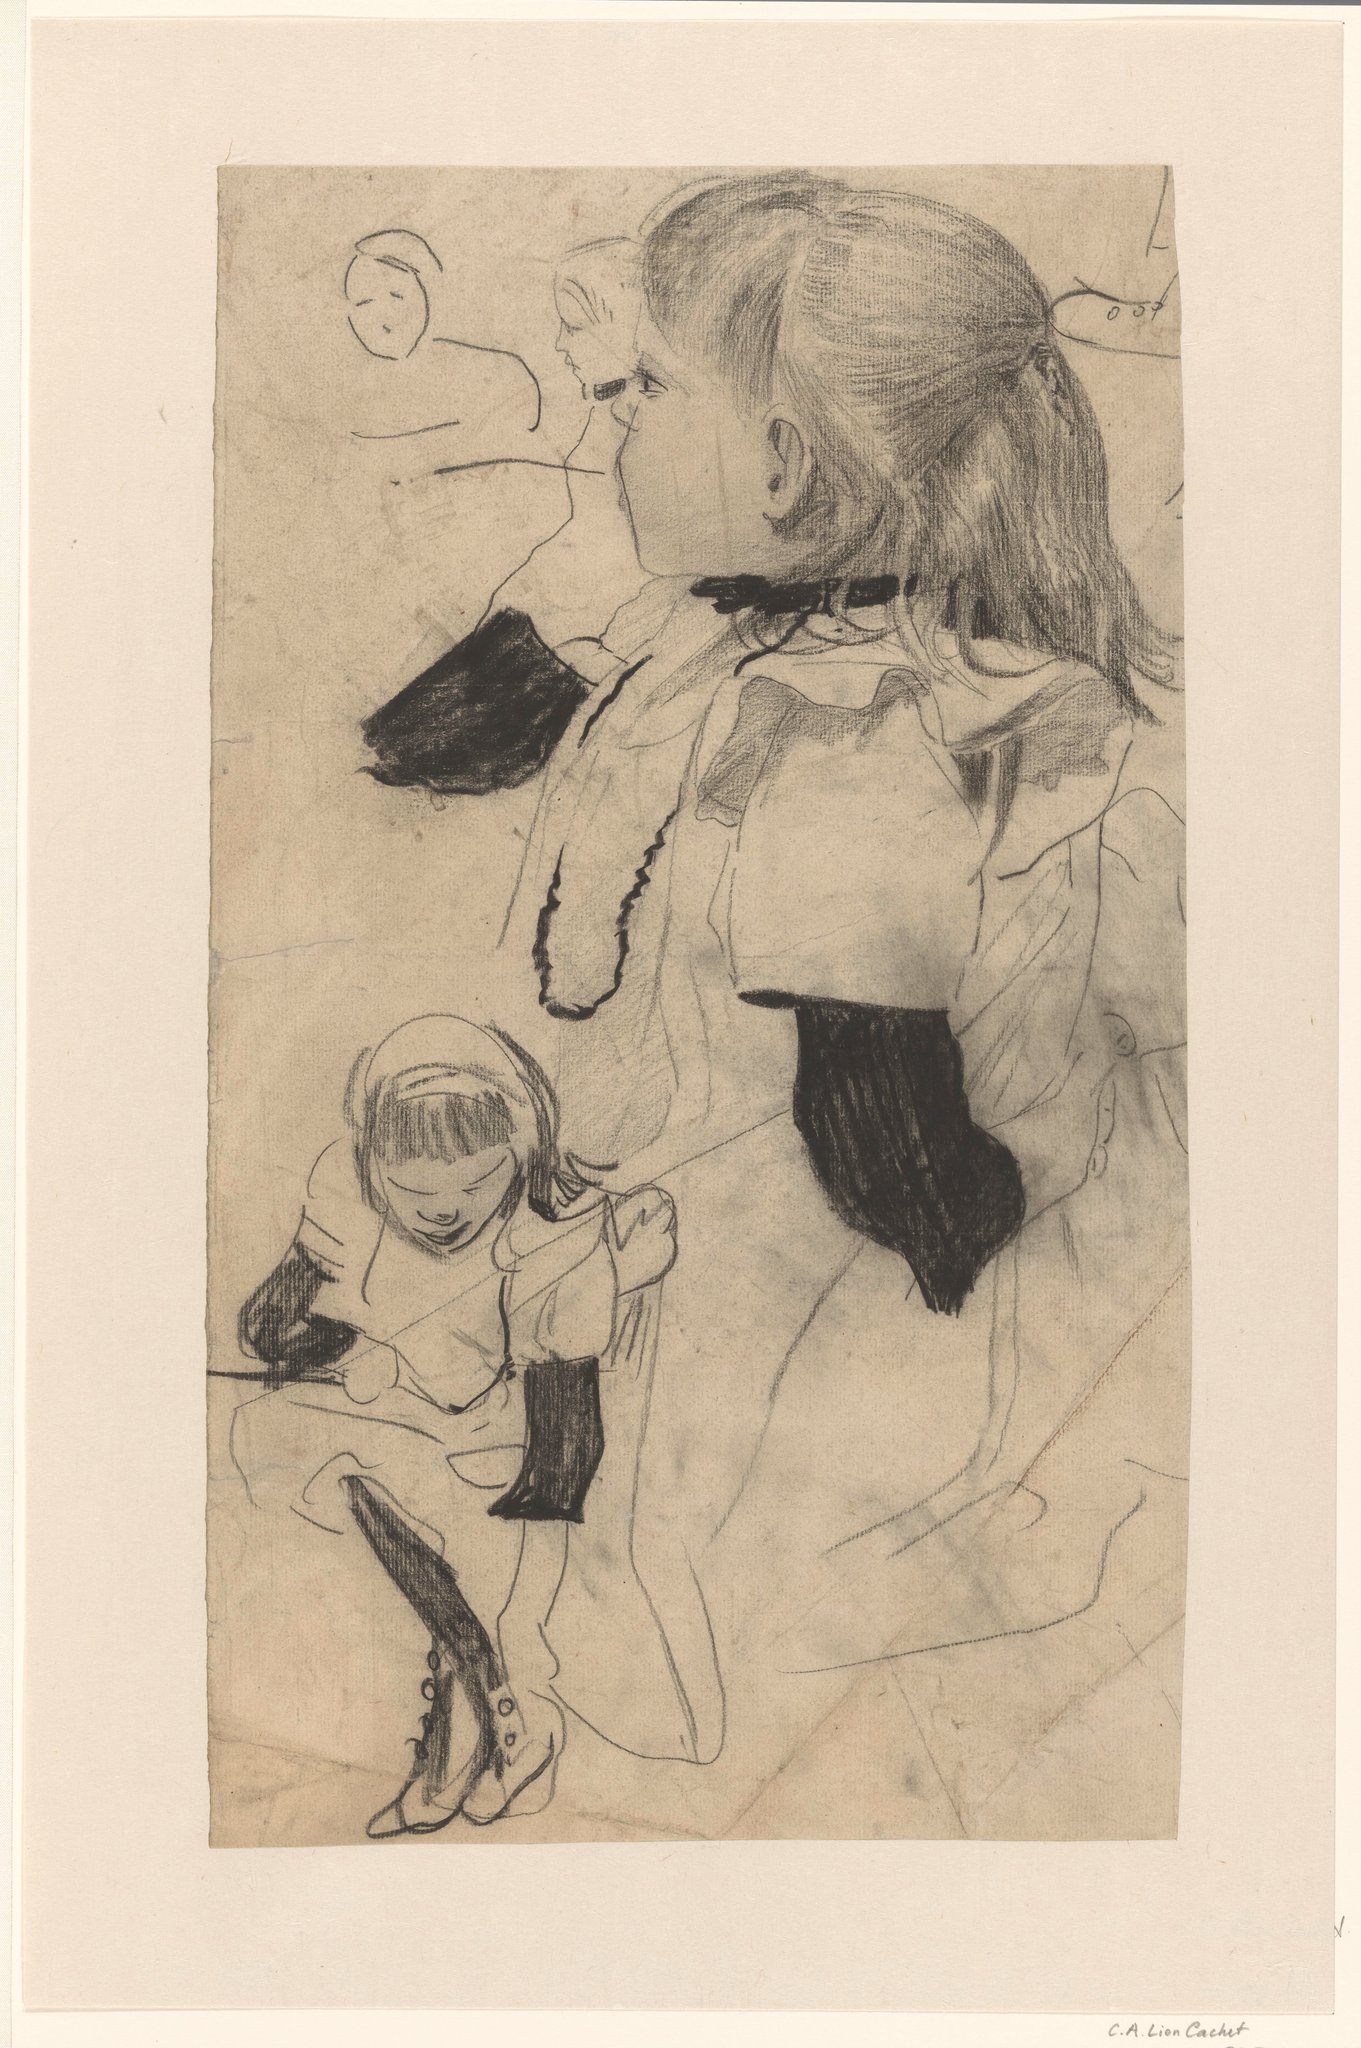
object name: drawing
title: Studies van een jong meisje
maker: carel adolph lion cachet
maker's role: draughtsman, print maker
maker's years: 1864-1945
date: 1874-1945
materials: chalk, paper